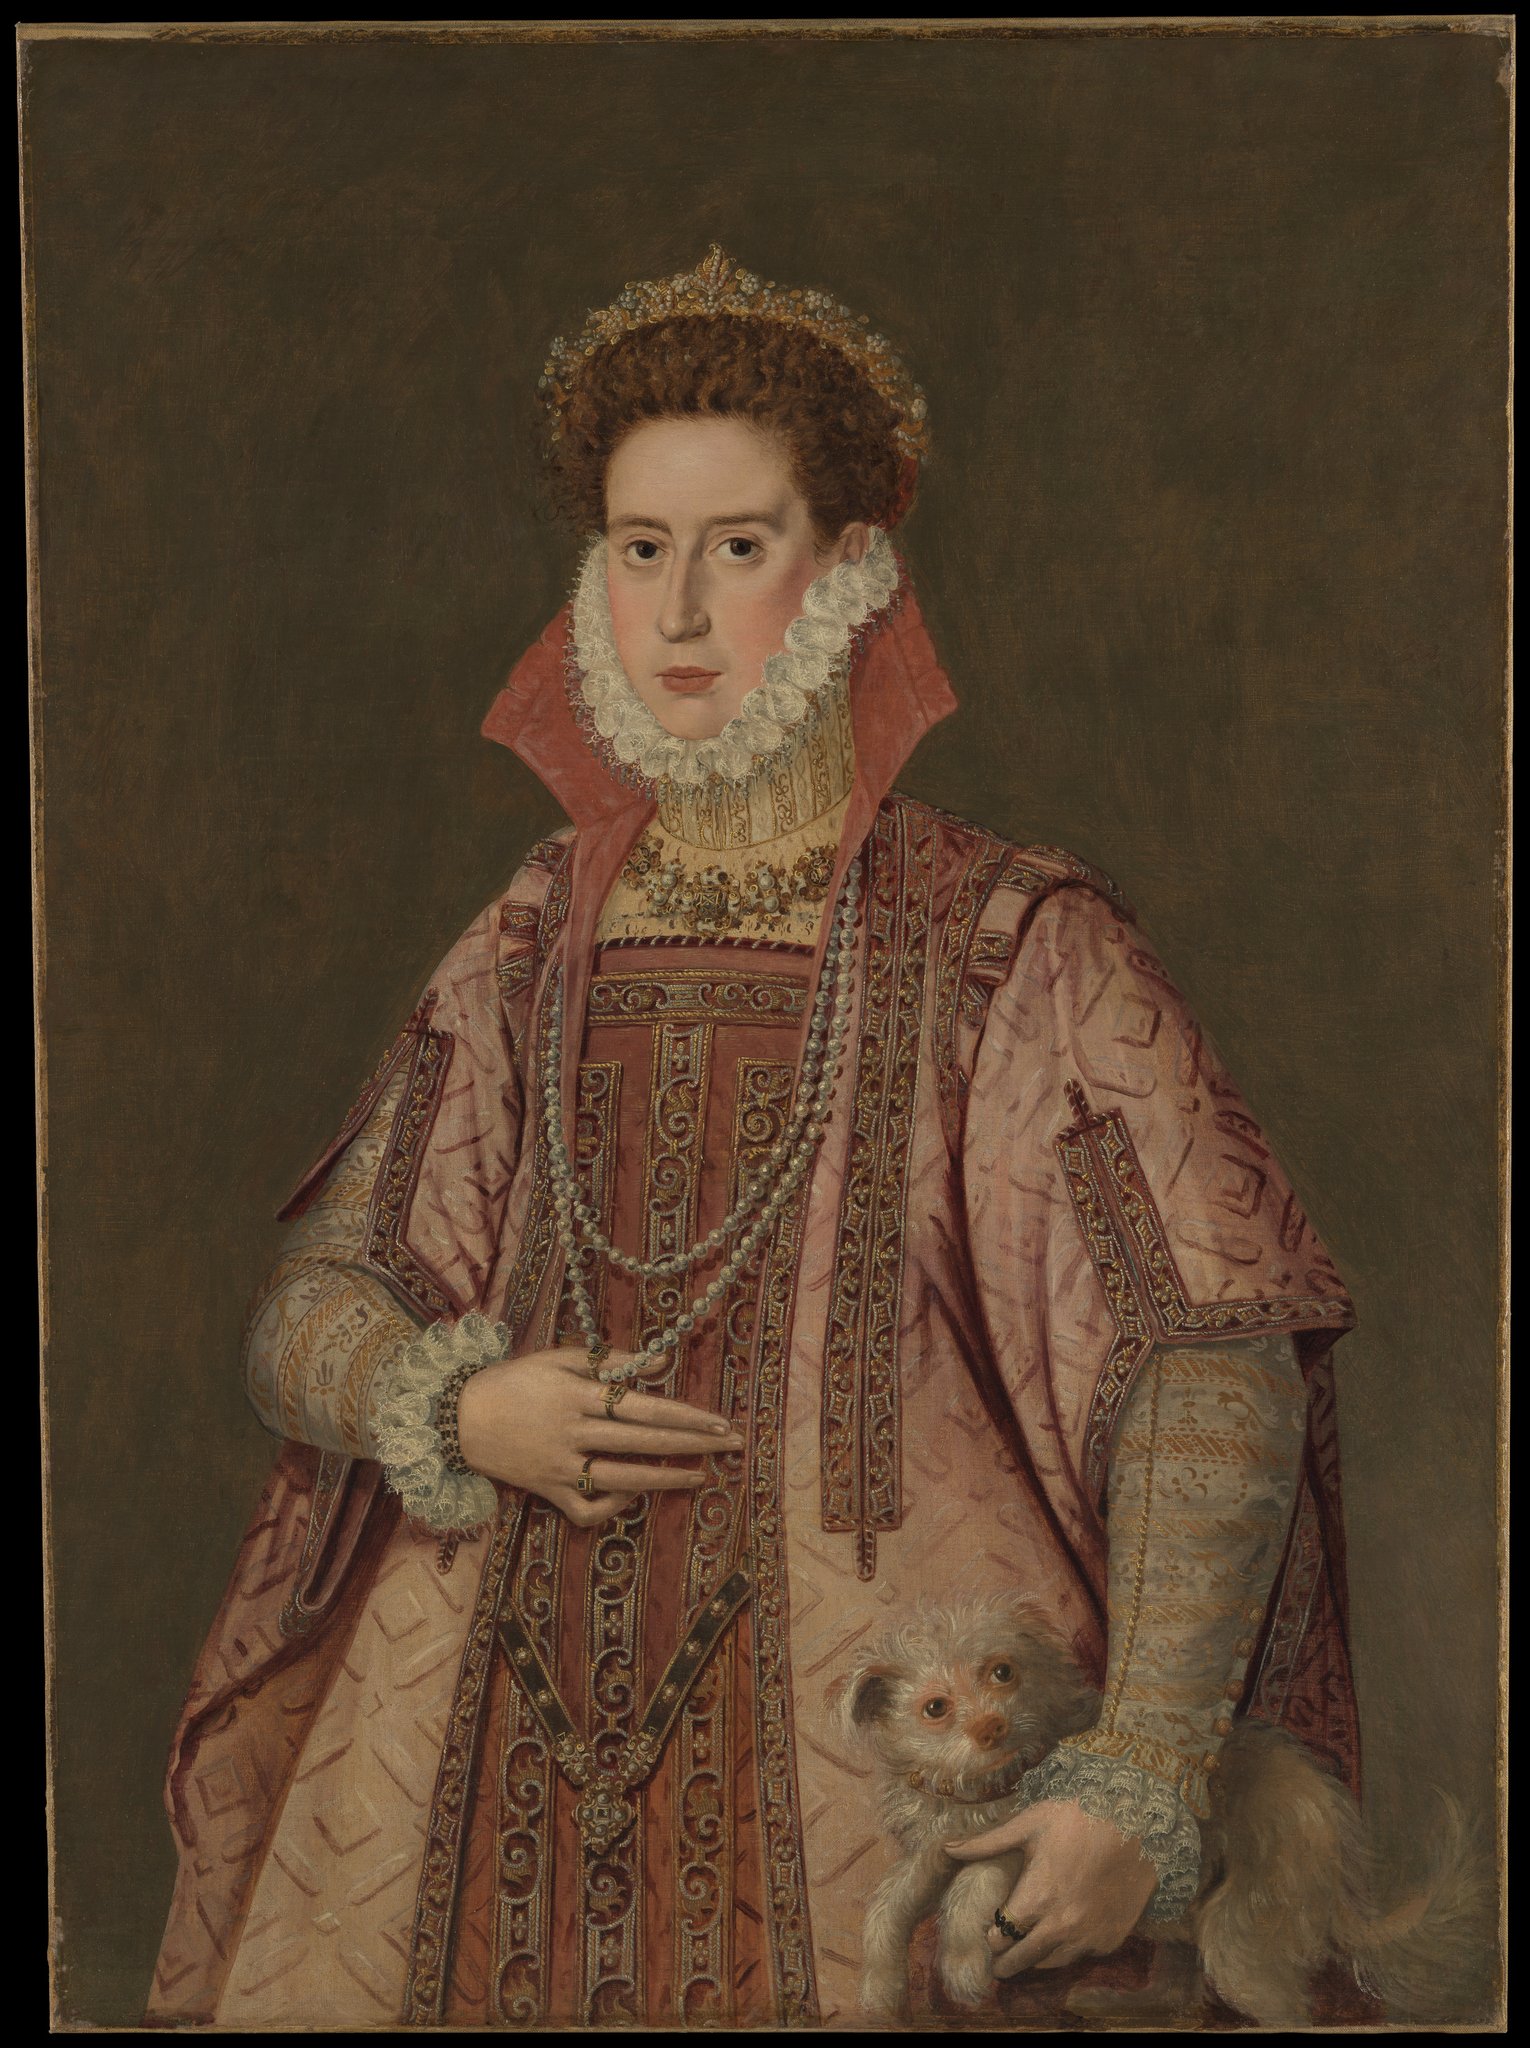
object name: painting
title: Portrait of a Woman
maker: rolán de moys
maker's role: artist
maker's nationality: netherlandish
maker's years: 1515-1592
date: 1551-1588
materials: canvas, oil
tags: portraits,women,dogs